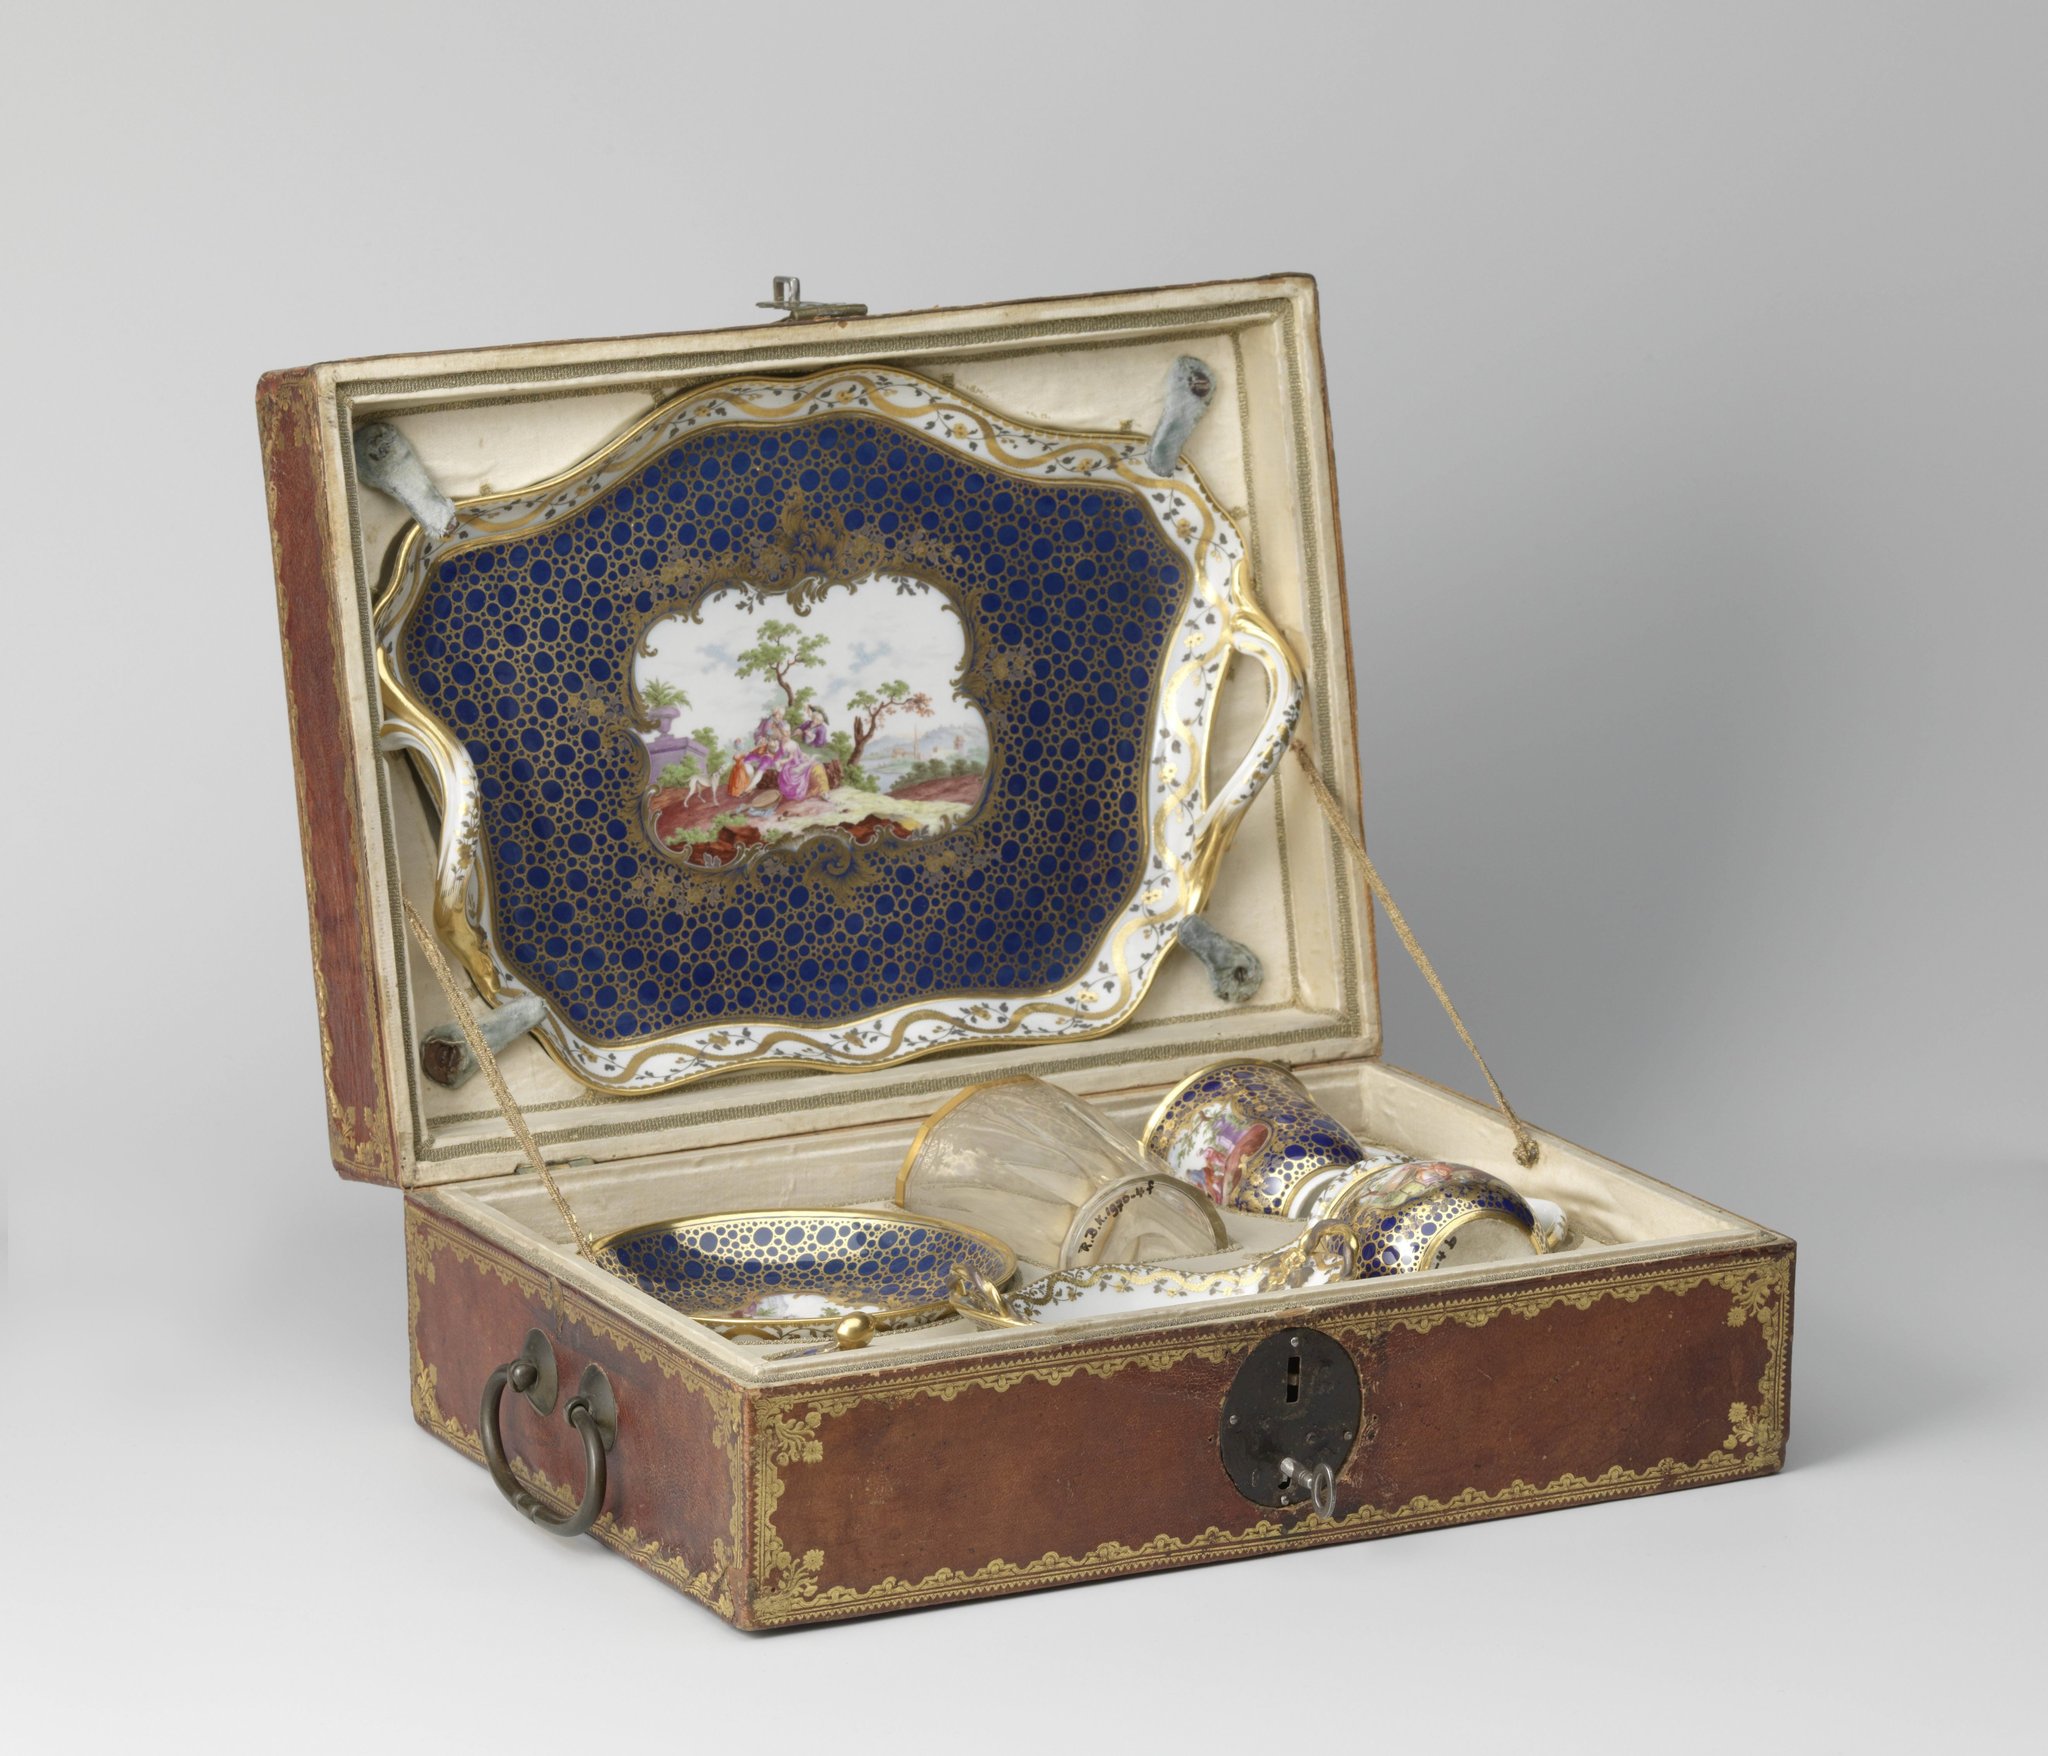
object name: suitcase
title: Service with figures in a landscape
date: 1765-1770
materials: glaze, gold, leather, paint, porcelain, silver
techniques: firing, gilding, turning, vitrification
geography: vienna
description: Service in original leather case. Porcelain. Vienna, c. 1765 - 1770.